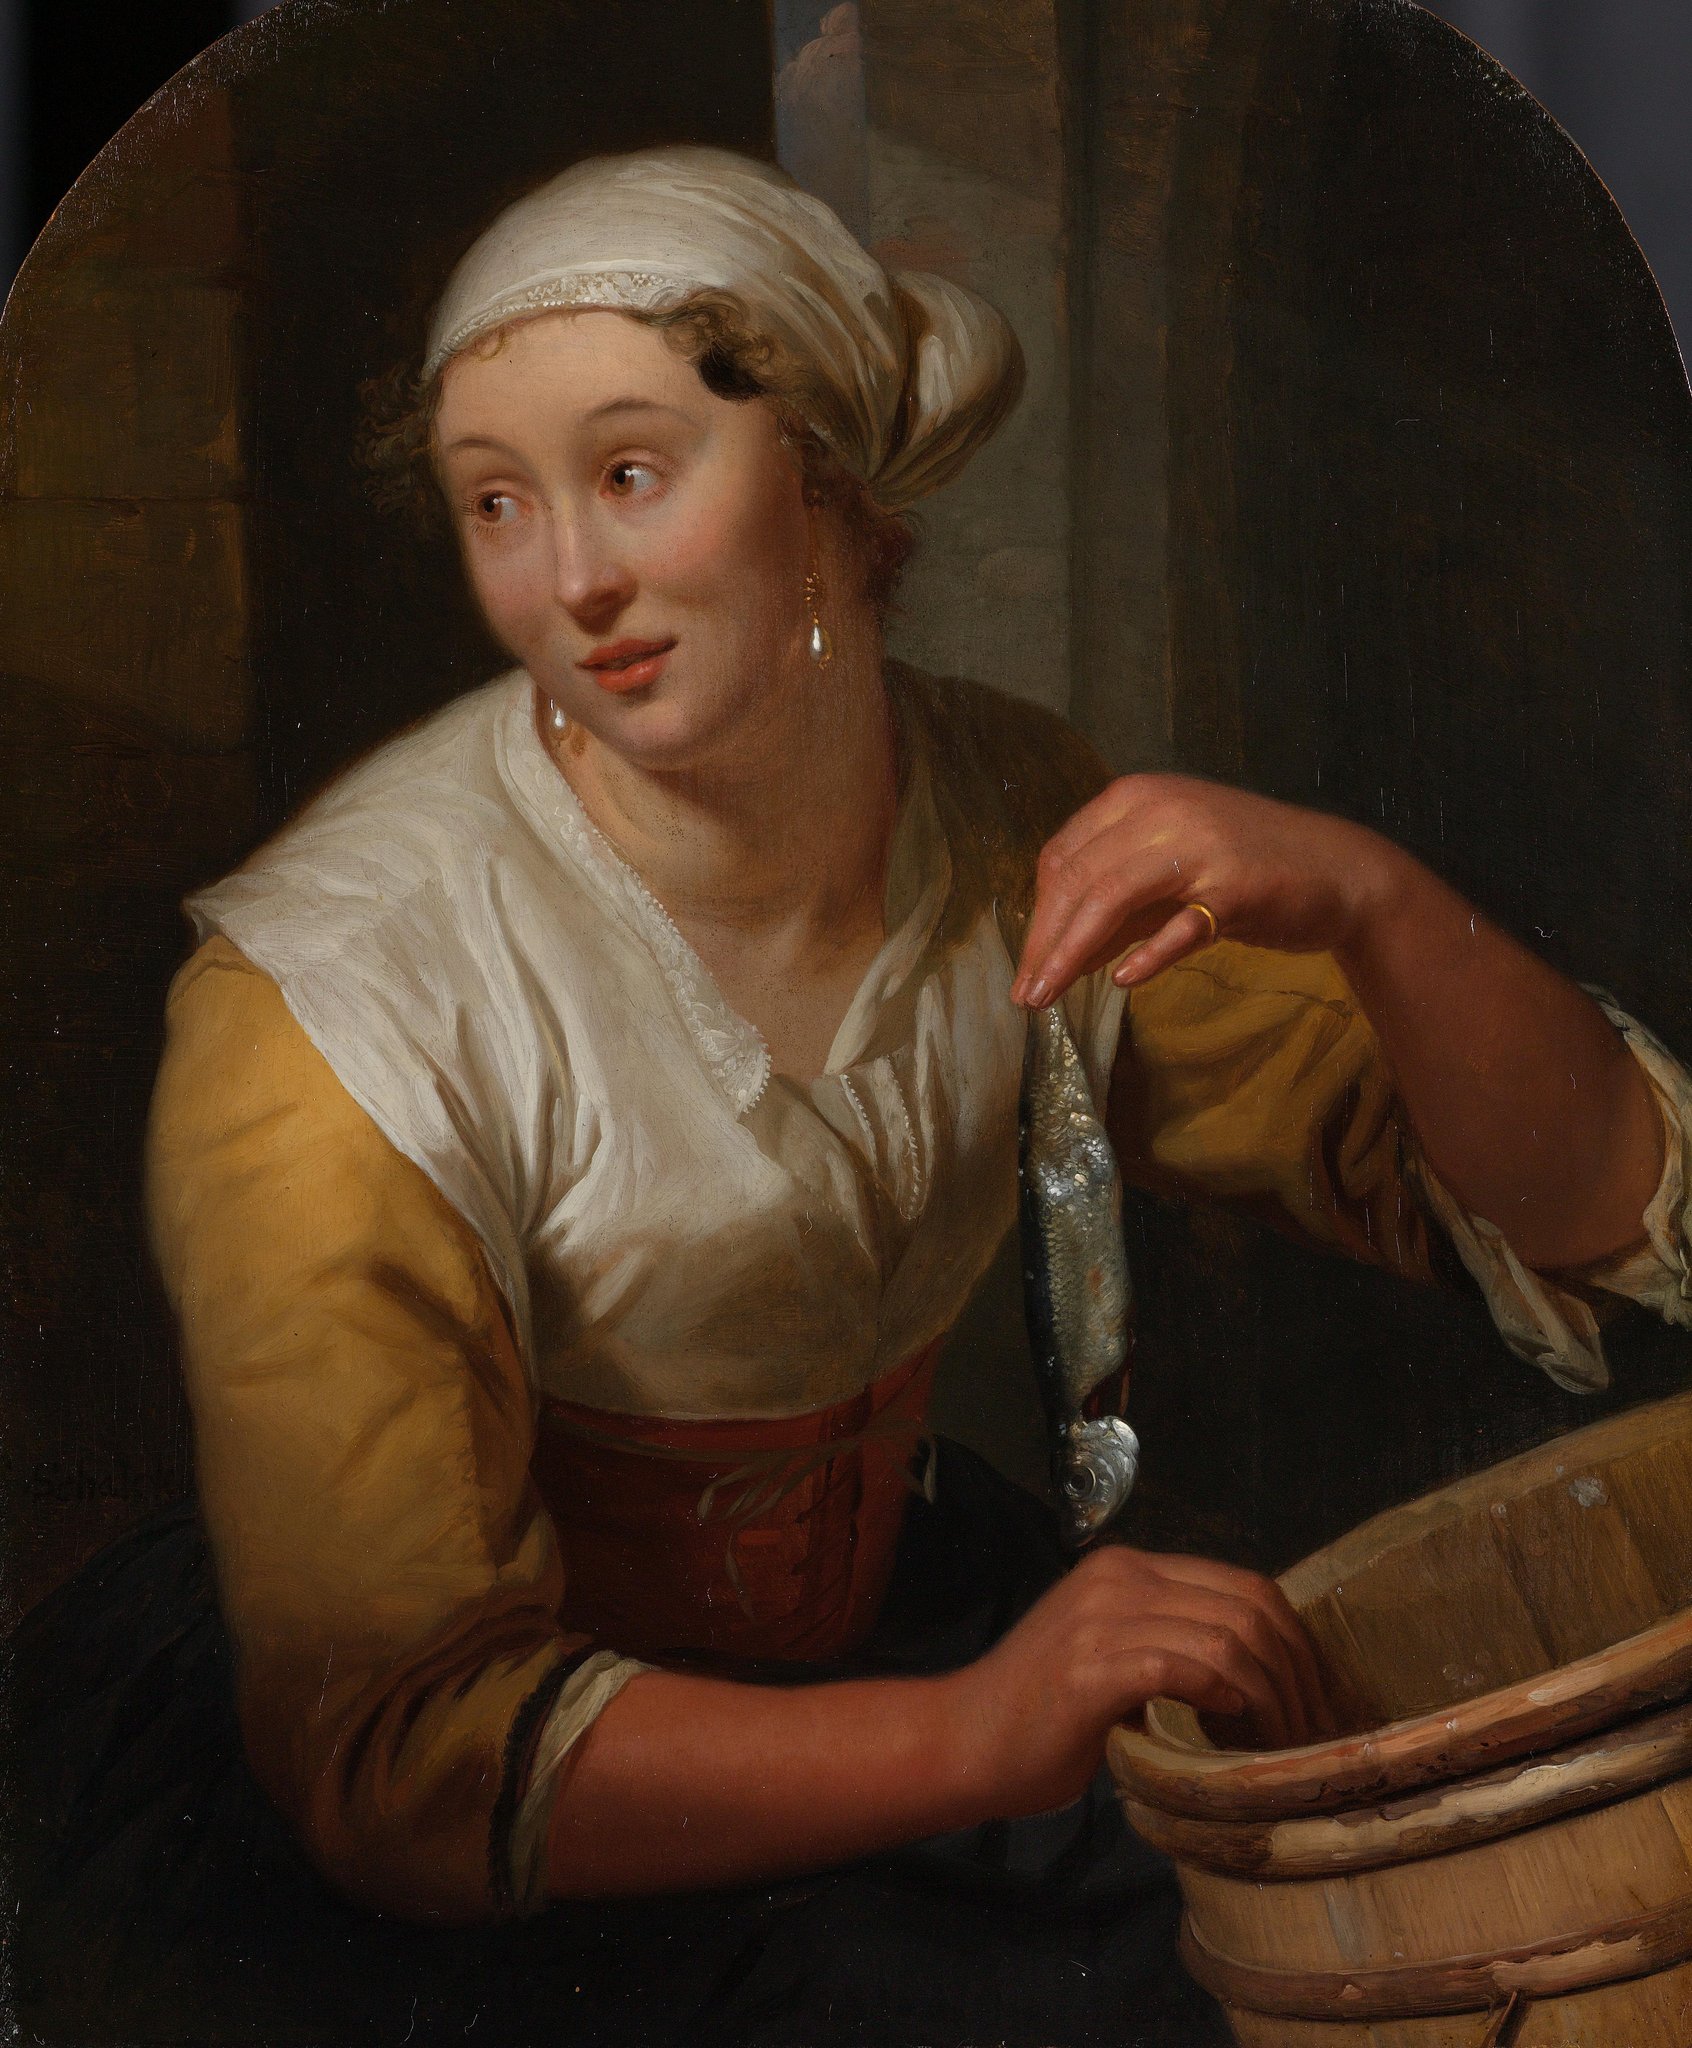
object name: painting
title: Woman Selling Herrings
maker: godfried schalcken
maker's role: draughtsman, painter, print maker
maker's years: 1643-1706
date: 1675-1680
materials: oil, panel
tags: adult woman, bony fishes: herring, merchant, salesman - bb - women engaged in trade and commerce, selling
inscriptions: signature: ‘G. Schalcke’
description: De haringverkoopster. Een jonge vrouw, ten halven lijve, houdt in haar linkerhand een haring omhoog, rechts een houten emmer.